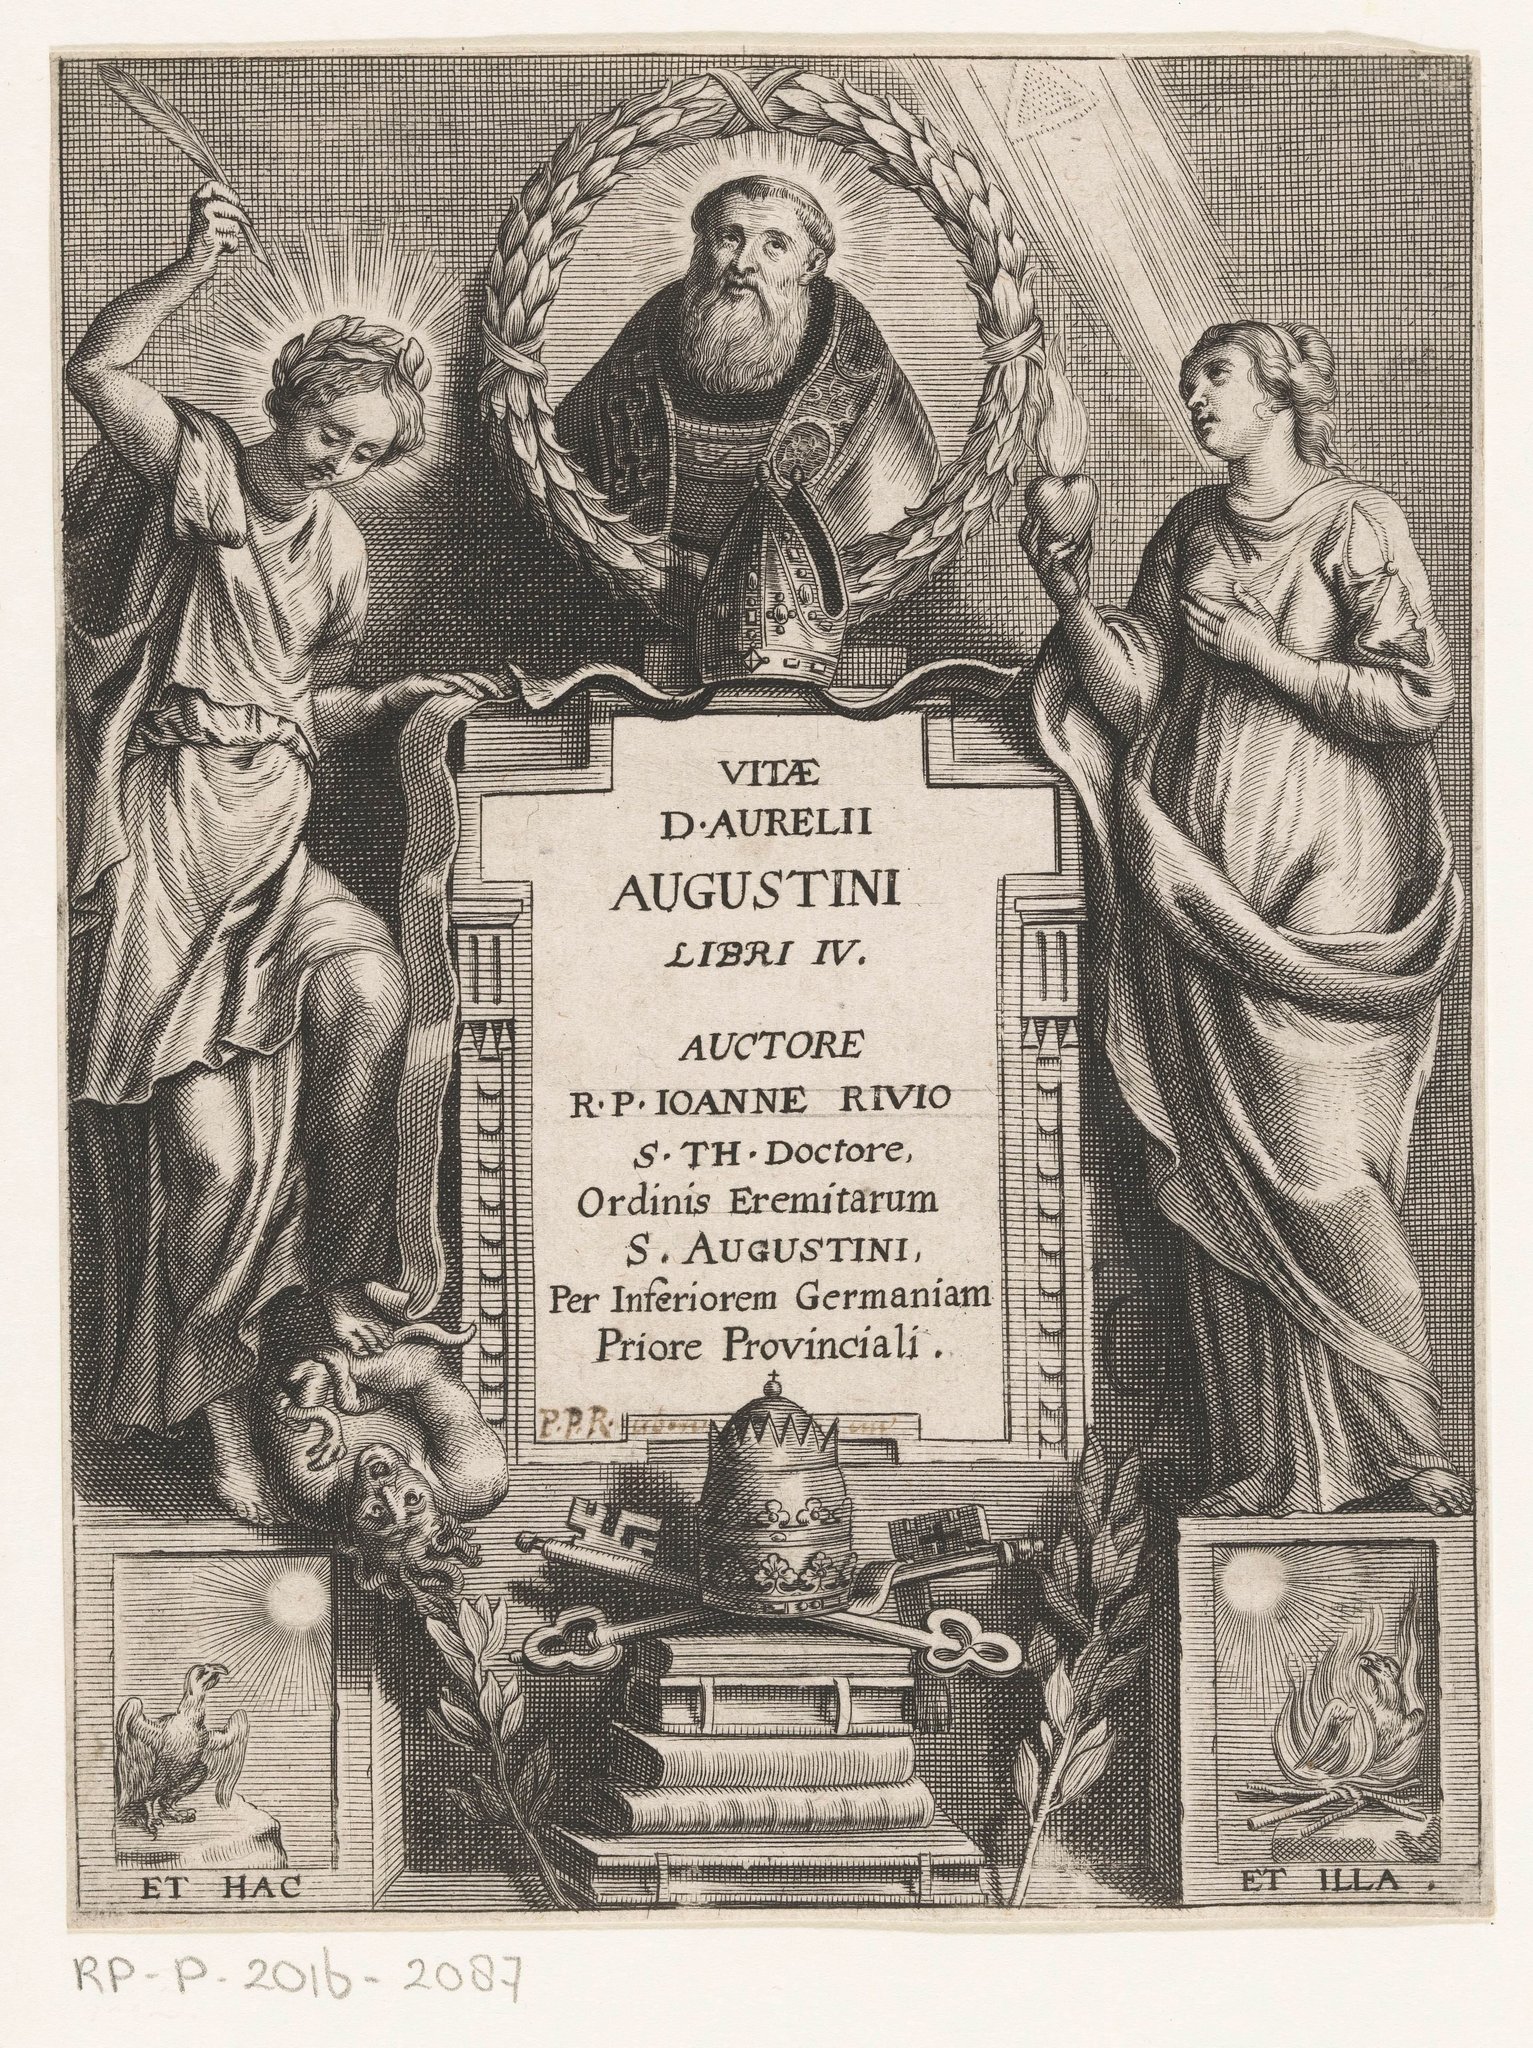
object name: titelblad, titelpagina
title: Vitae D. Aurelii Augustini Libri IV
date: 1646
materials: paper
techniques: engraving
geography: antwerp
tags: augustine, bishop of hippo; possible attributes: arrows piercing his breast, book, child with spoon, flaming heart, heart (pierced with arrows), pen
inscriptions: collector's mark: Lugt 240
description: Boven een tablet met titel een portretmedaillon van kerkvader Augustinus van Hippo. Links vertrapt een vrouw met schrijfveer een duivelse figuur. Rechts staat een vrouw met brandend hart in de hand, vanuit de hemel wordt zij beschenen. Aan de voorzijde liggen boeken, sleutels en de pauselijke tiara.